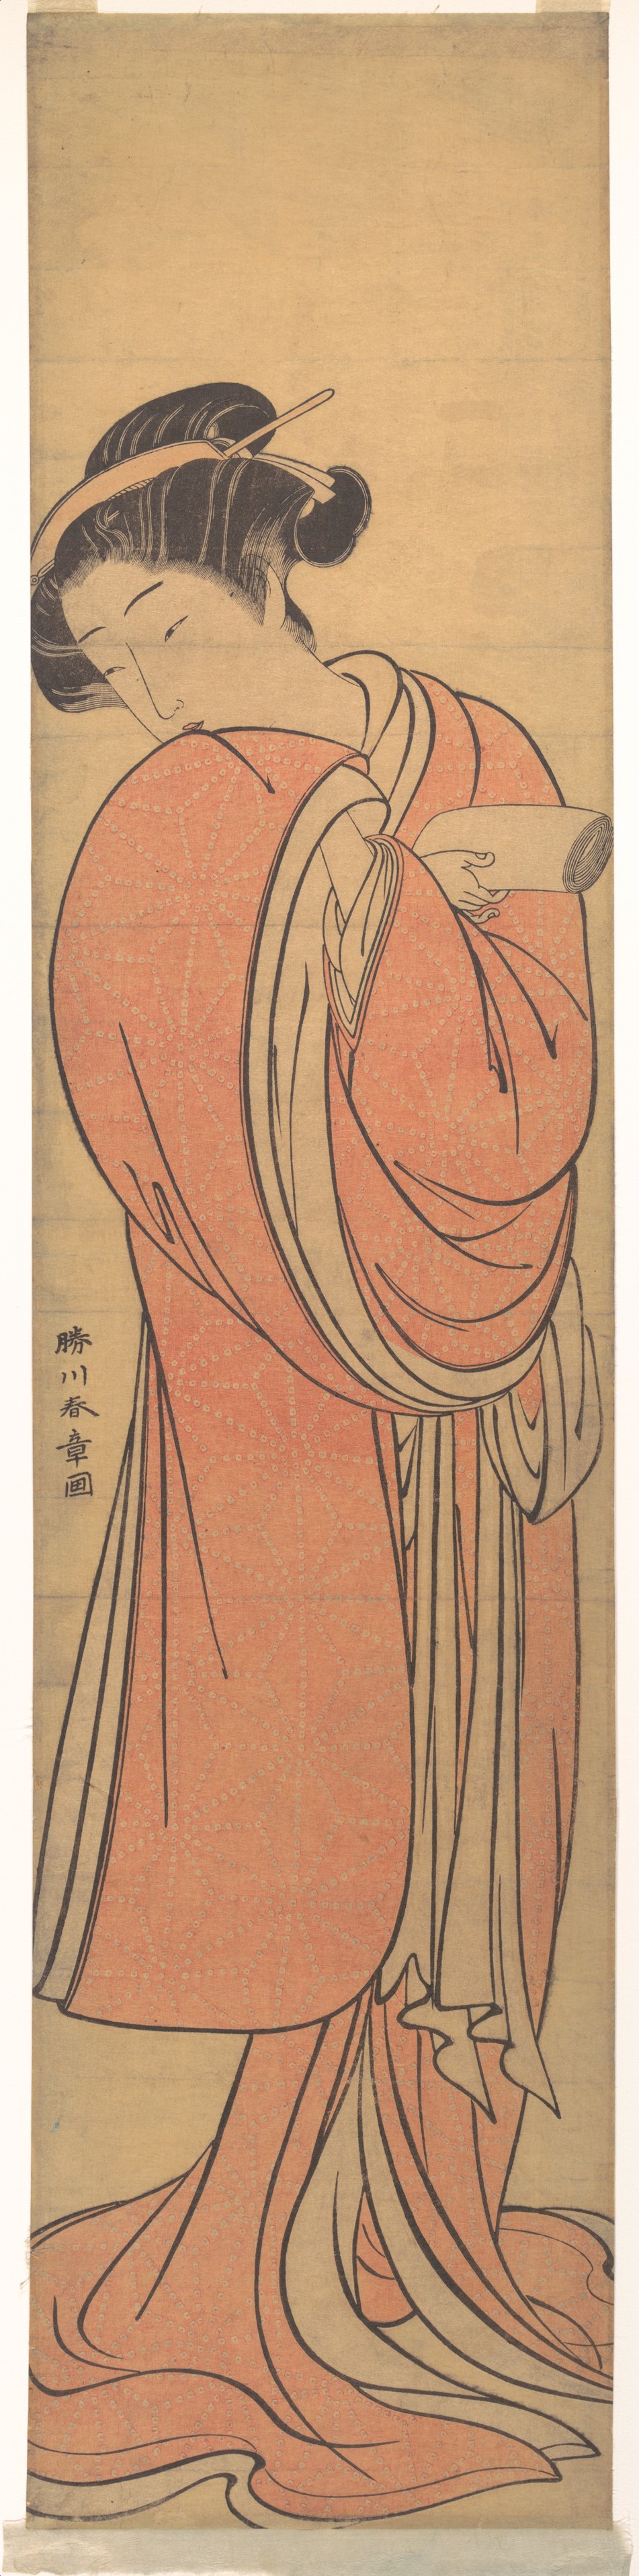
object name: woodblock print nishiki e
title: Woman in Red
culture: japanese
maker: katsukawa shunshō 勝川春章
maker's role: artist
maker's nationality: japanese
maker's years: 1726-1792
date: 1767-1800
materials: ink, paper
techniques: nishiki e, woodblock print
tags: women